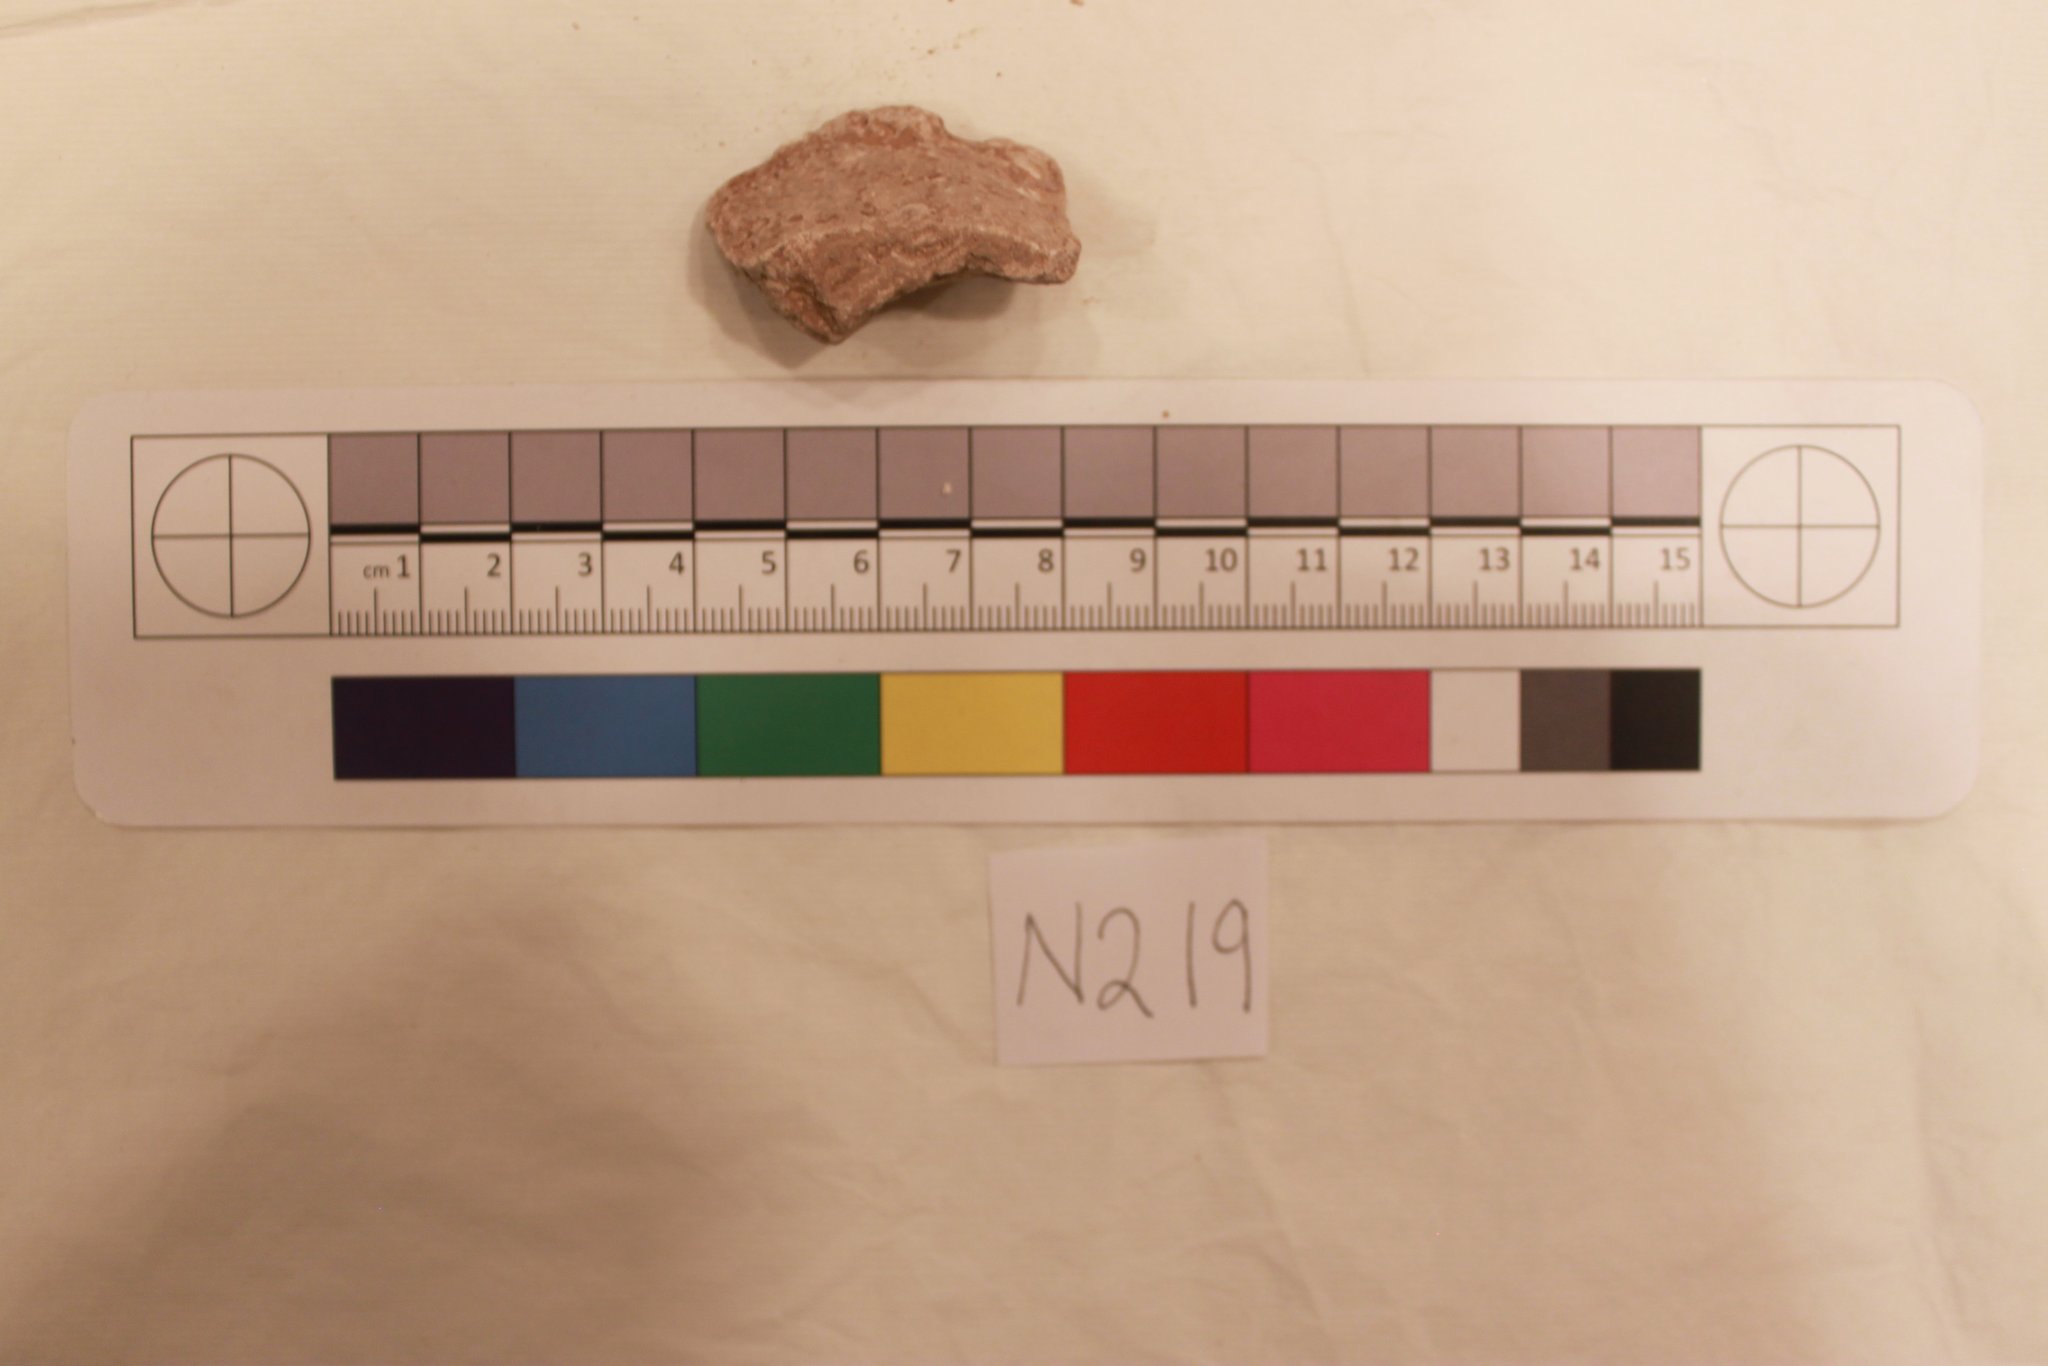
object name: fragment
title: Stucco Fragment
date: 701-1200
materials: plaster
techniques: carving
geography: iran